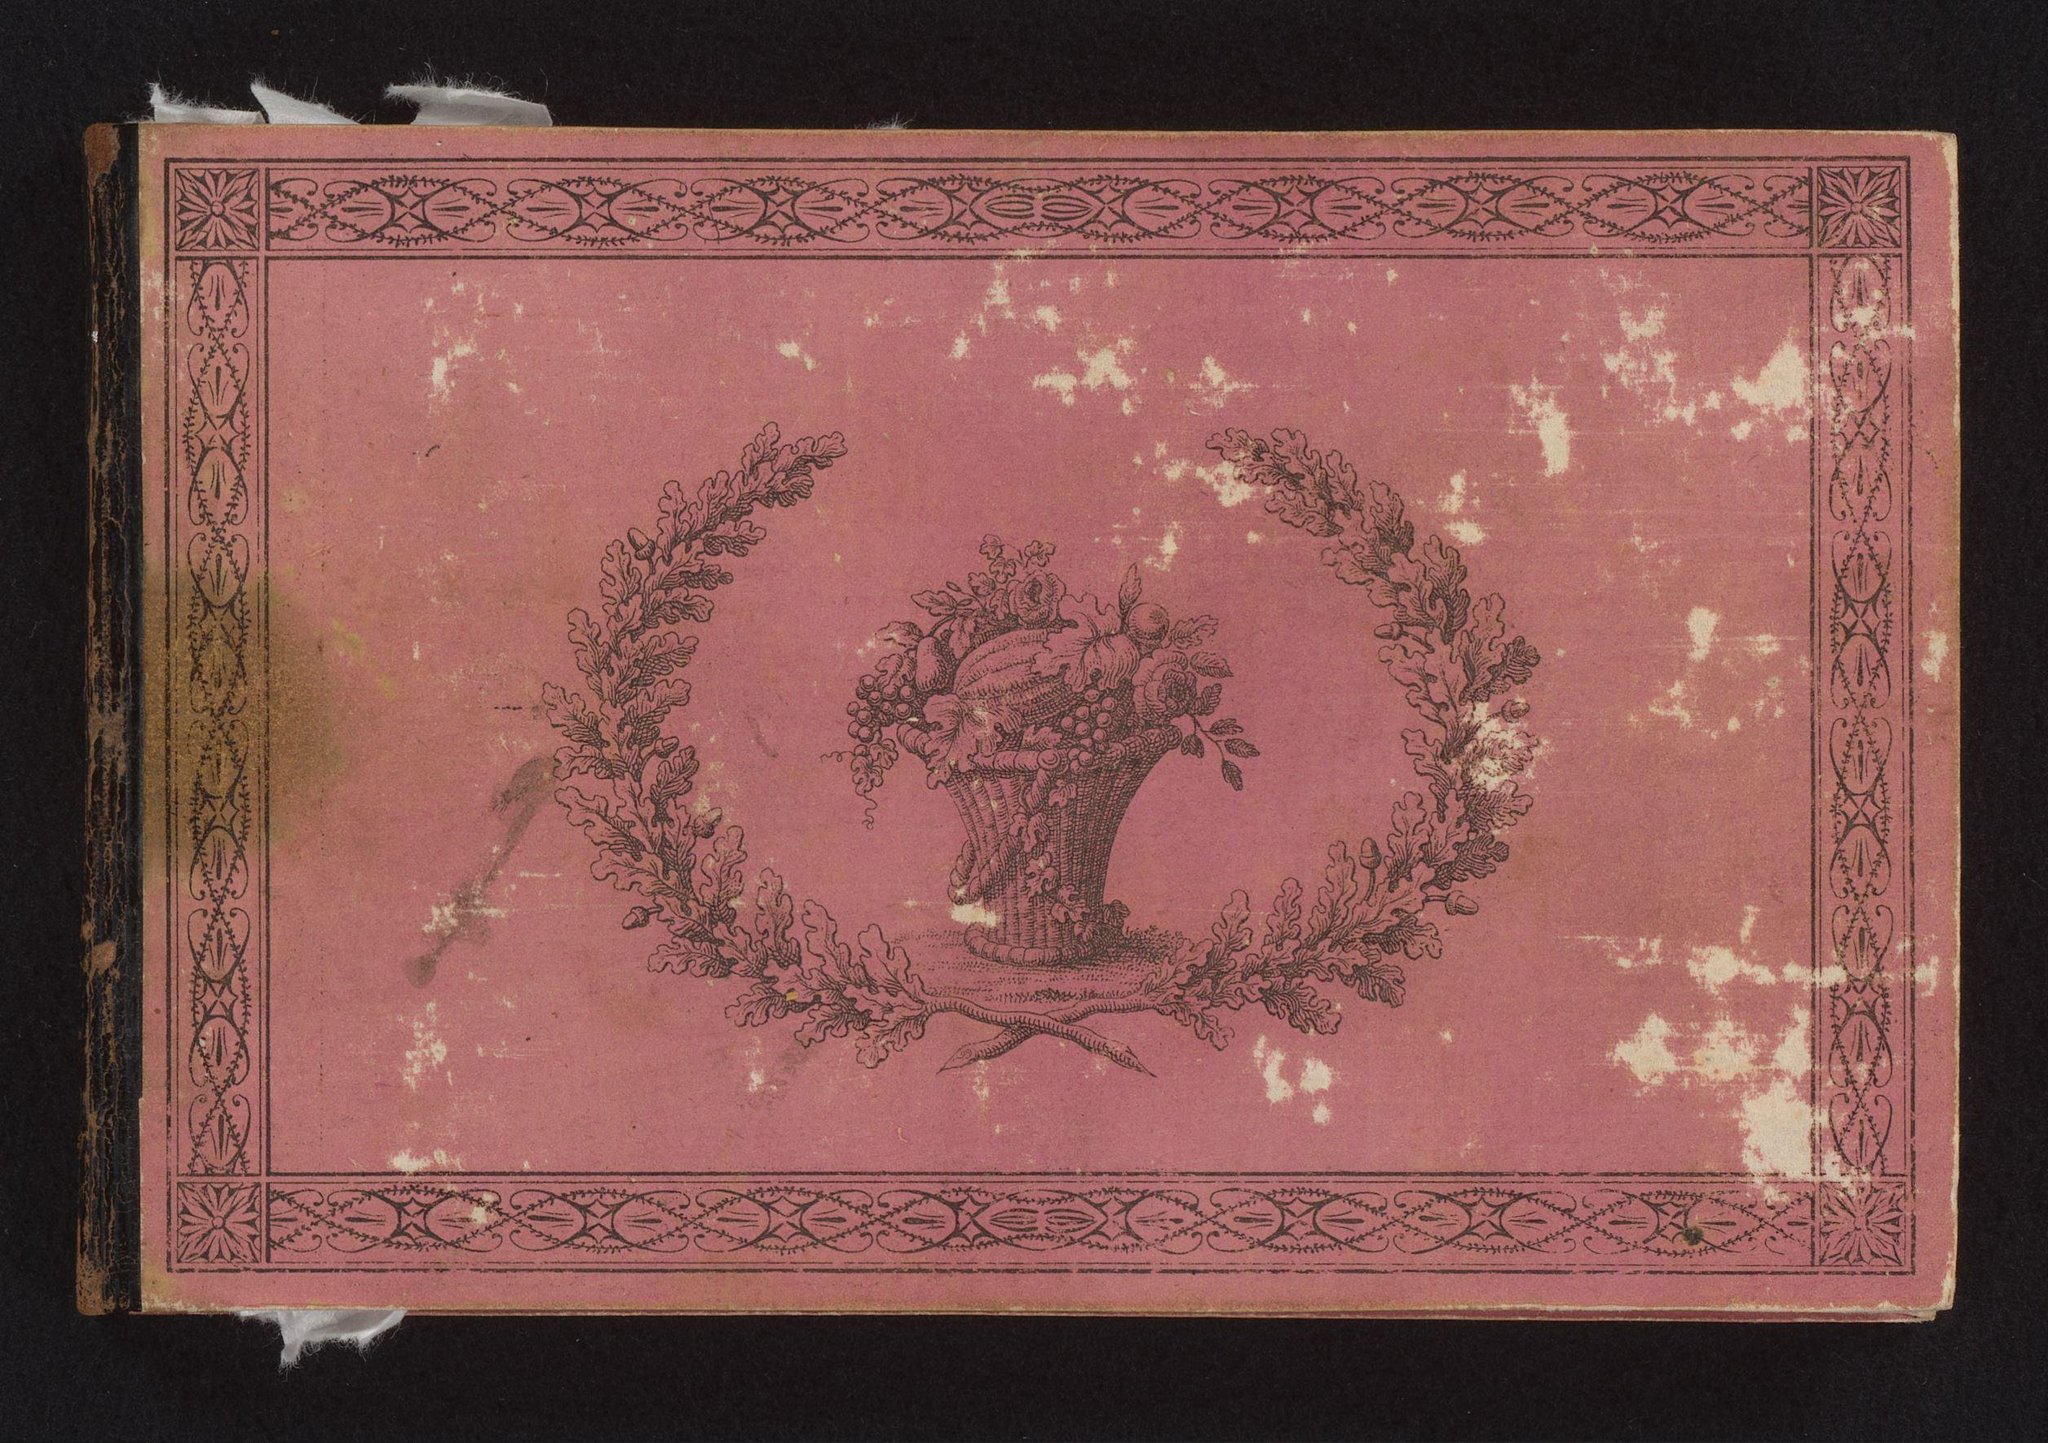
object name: wrapper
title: Omslag met ornamentele omlijsting voor 42 prenten van landschappen in Duitsland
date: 1770-1826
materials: cardboard, leather, paper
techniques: decorated paper, etching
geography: gottingen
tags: wooden container: barrel, cask, bucket, fruits and vegetables ~ ornament, 'album amicorum', 'stammbuch'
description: Album amicorum met 42 prenten. Bij alle prenten, op twee na, bevat het verso een opdracht, persoonlijk handgeschreven tekst en/of tekening. De cassette, omslag en prenten zijn mogelijk als geheel uitgegeven door Johann Carl Wiederhold in Göttingen.